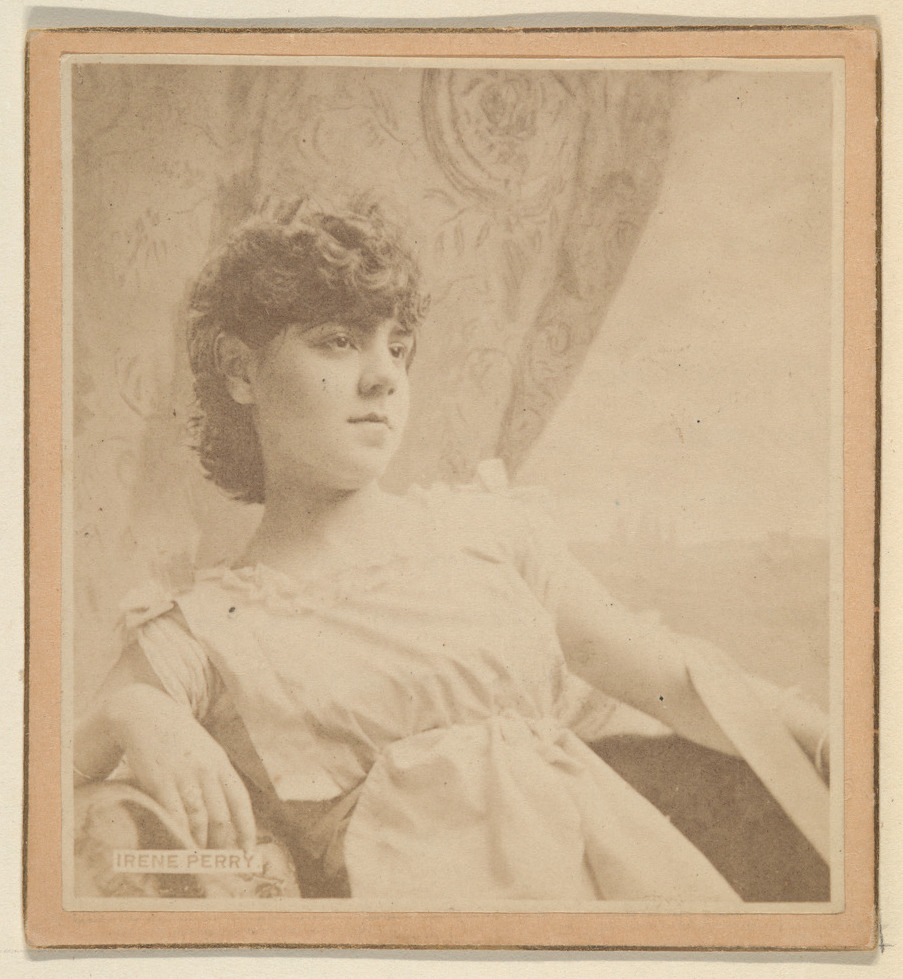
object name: photograph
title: Irene Perry, from the Actresses series (N246), Type 2, issued by Kinney Brothers to promote Sporting Extra Cigarettes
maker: kinney brothers tobacco company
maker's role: publisher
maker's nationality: american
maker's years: 1869-2011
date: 1890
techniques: albumen silver print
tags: portraits,women,actresses